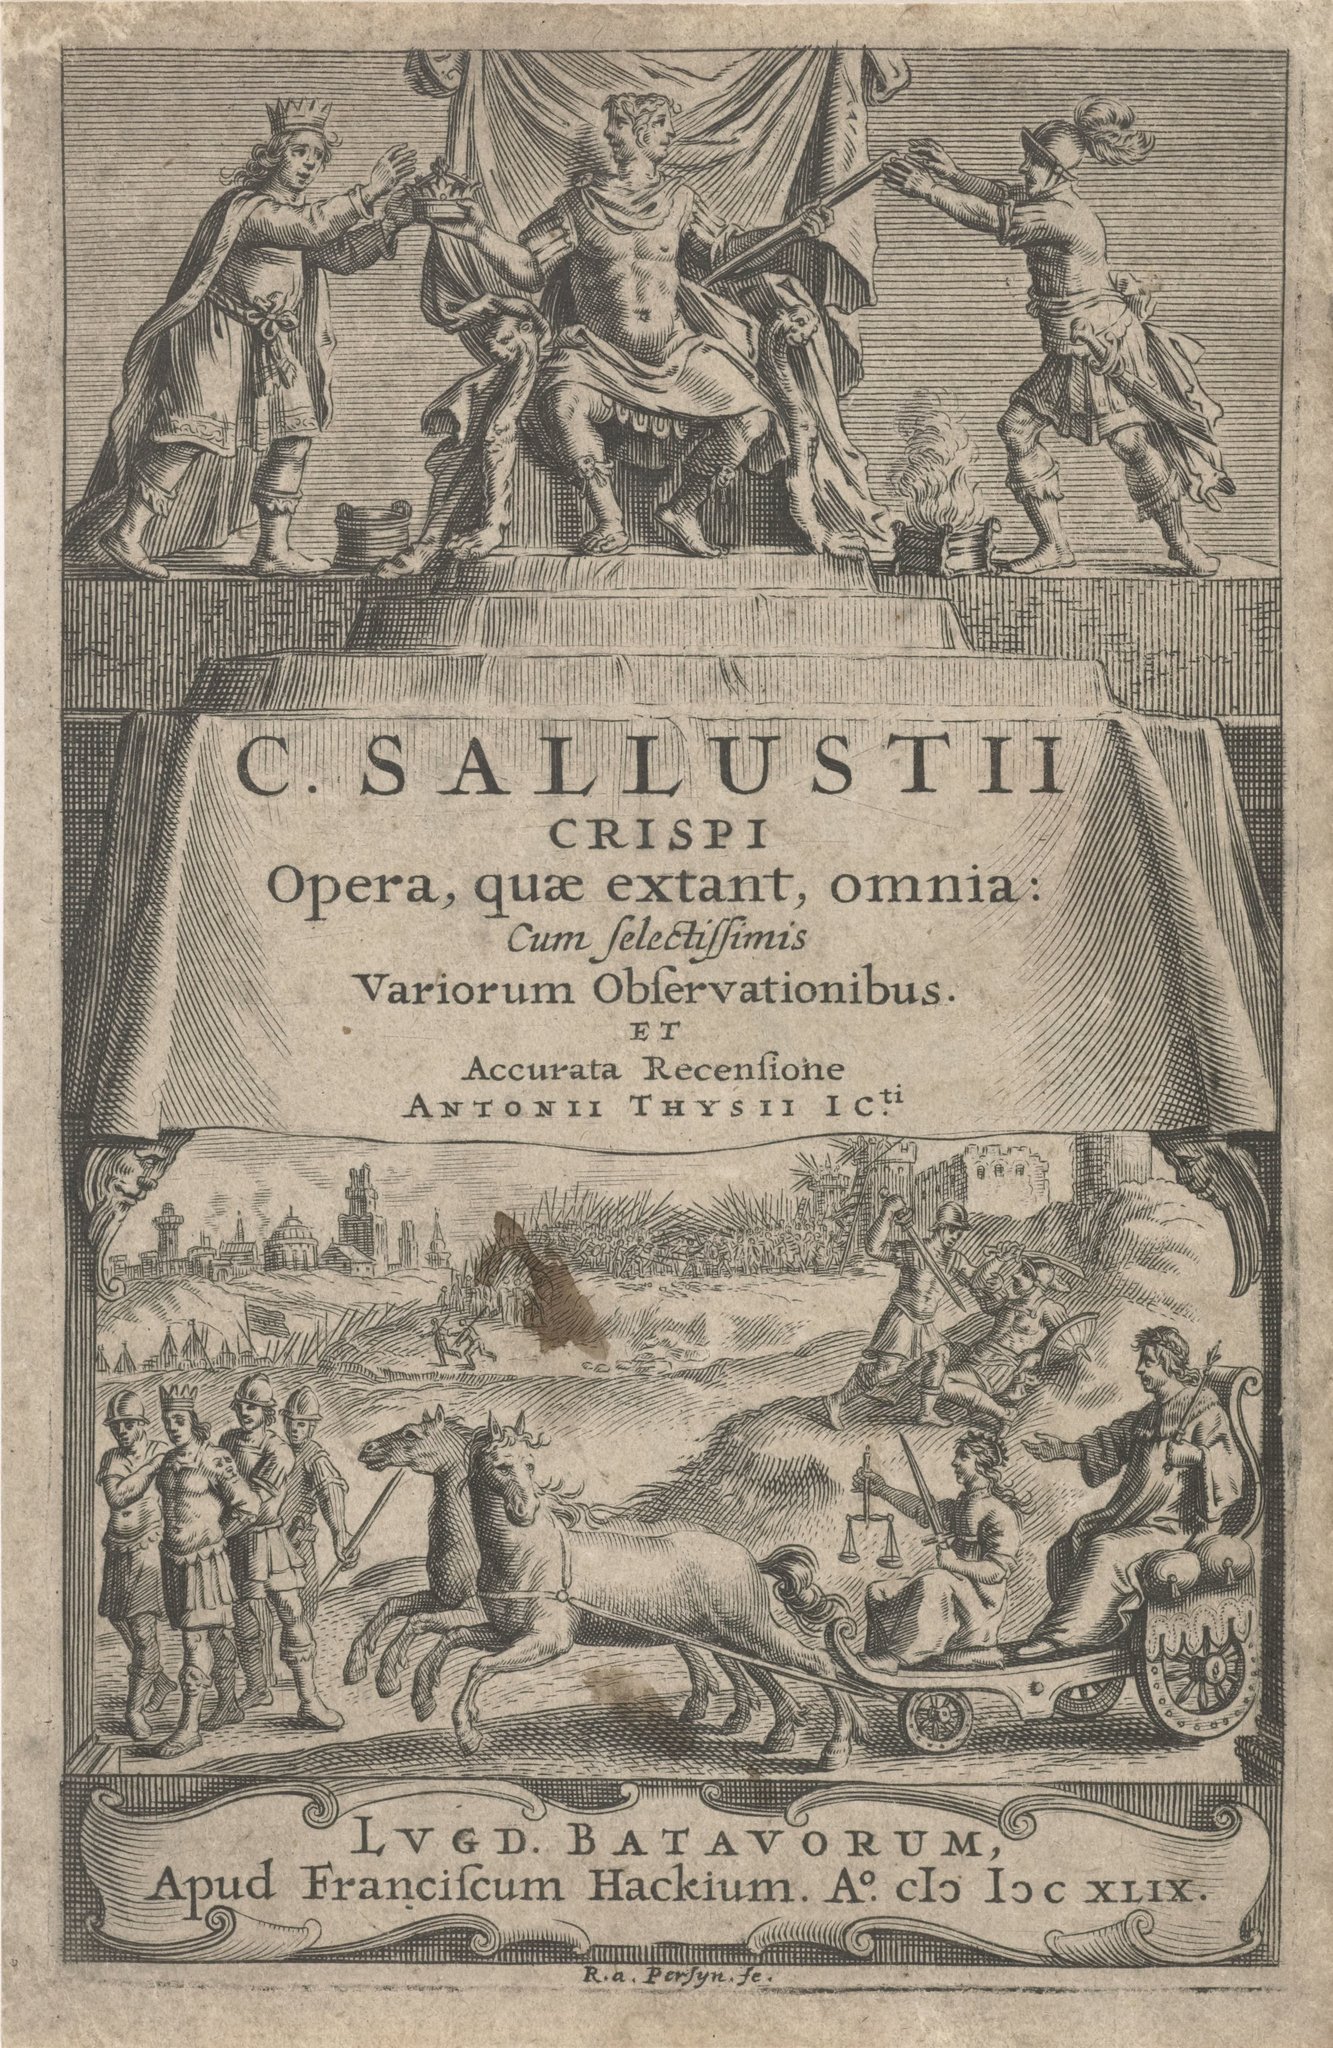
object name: titelblad, titelpagina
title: Een keizer en Rechtvaardigheid op triomfwagen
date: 1649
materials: paper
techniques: engraving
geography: gouda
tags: justice, 'justitia'; 'giustitia divina' (ripa) ~ one of the four cardinal virtues, siege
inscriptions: collector's mark: Lugt 2228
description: Landschap met een veldslag. Een prins wordt door soldaten gevangen genomen. Op de voorgrond een keizer en de personificatie van Rechtvaardigheid op een triomfwagen. In het midden op een doek de titel in het Latijn. Daarboven een soldaat op een troon in tweestrijd. Hij overhandigt een kroon aan een koning en een zwaard aan een soldaat.